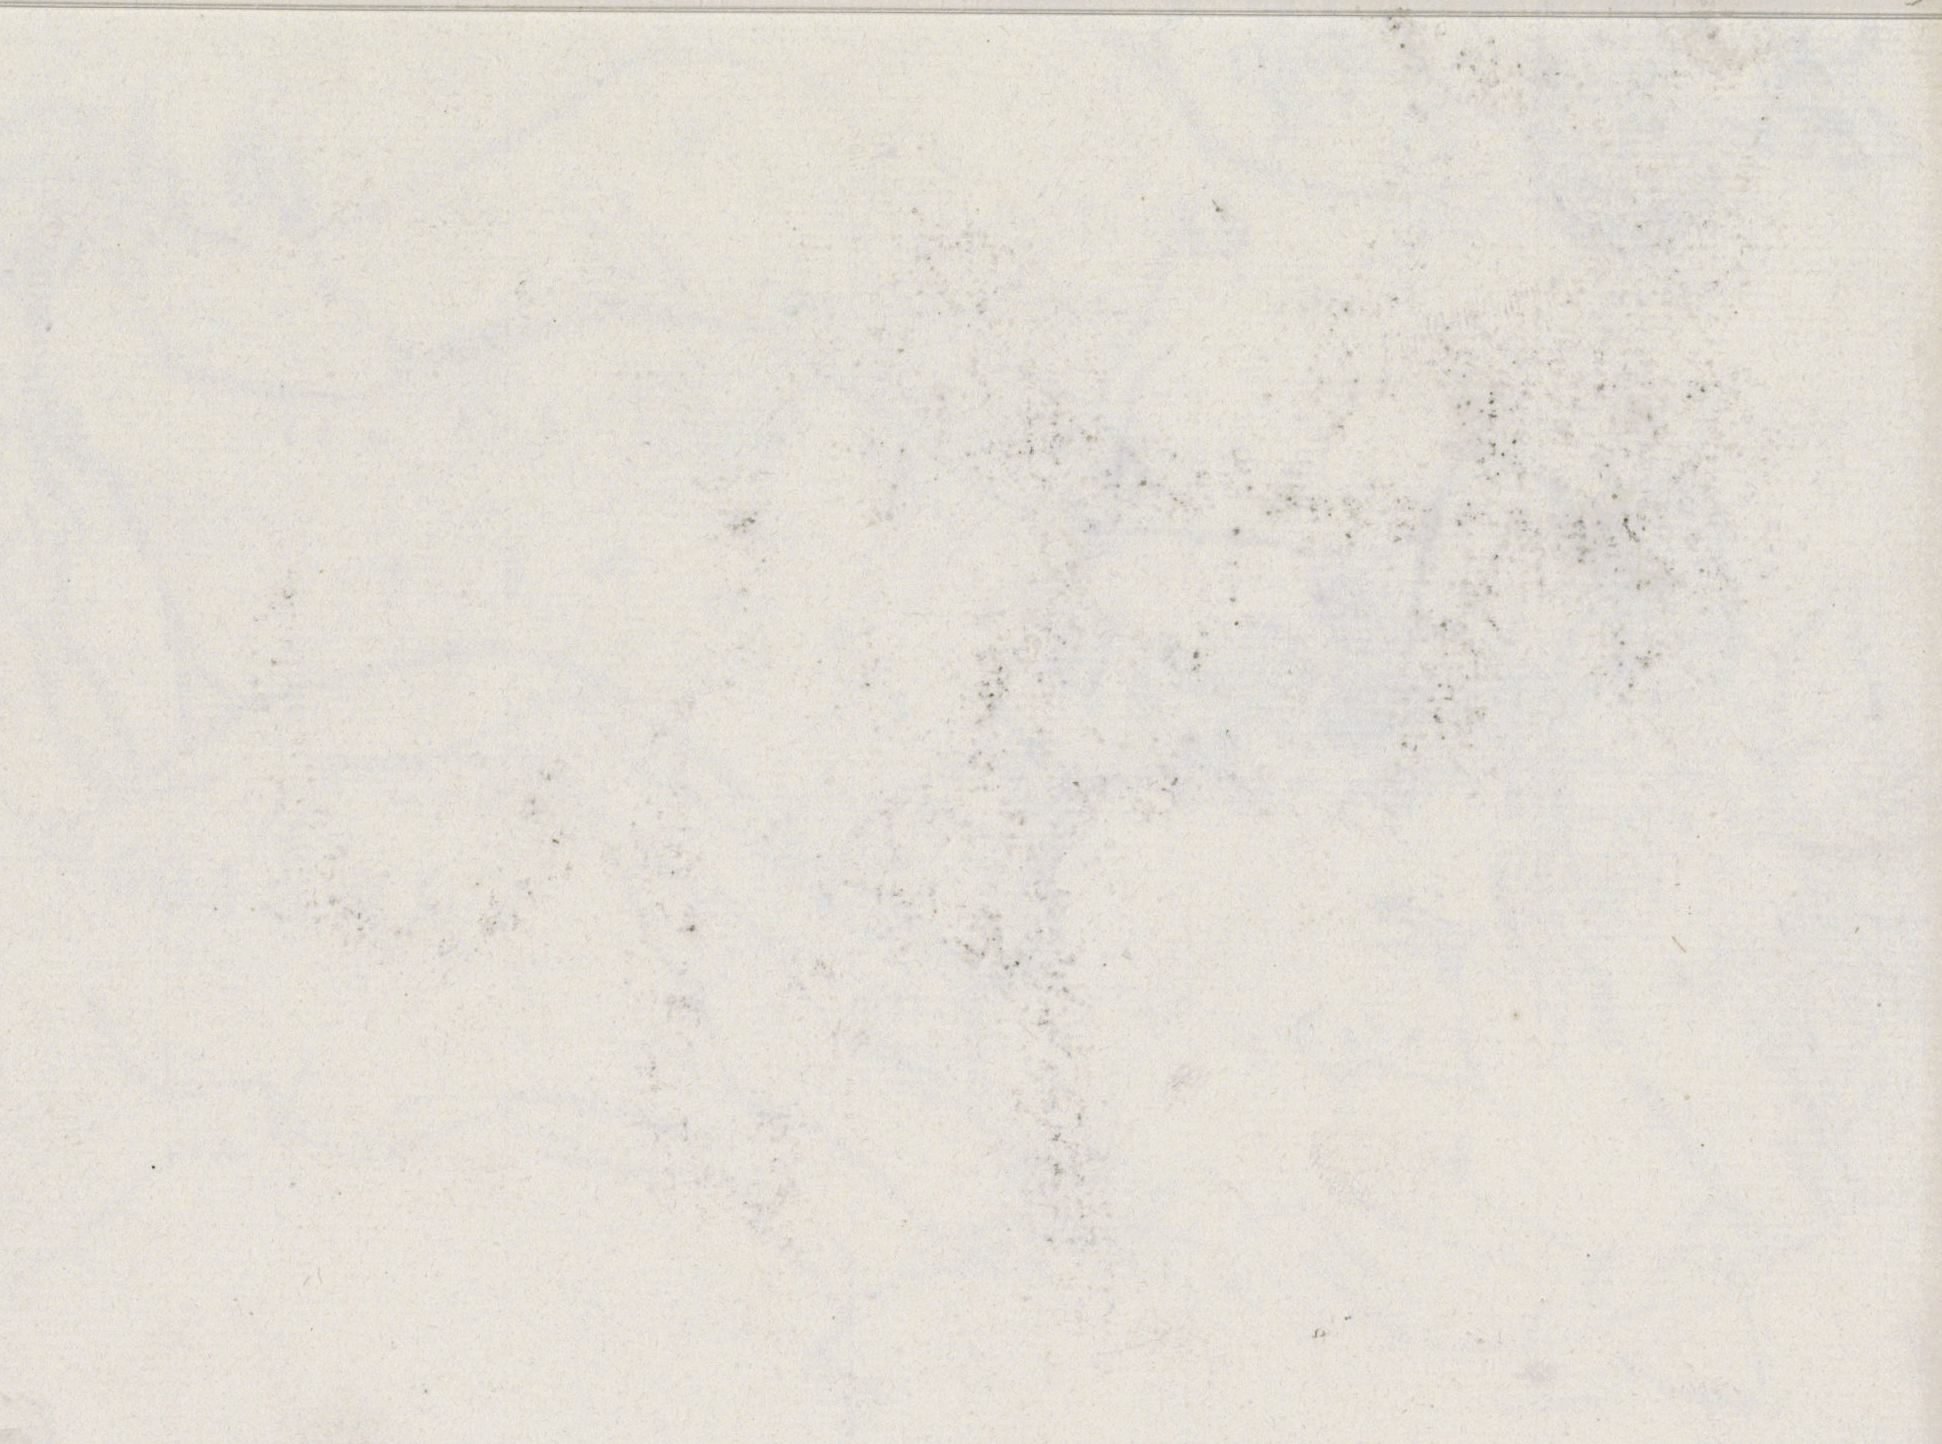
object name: sketchbook leaf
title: Aklatsch van de krijttekening op pagina 28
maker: isaac israels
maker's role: draughtsman, painter, print maker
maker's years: 1865-1934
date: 1875-1934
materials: paper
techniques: printmaking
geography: the hague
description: Pagina 29 uit schetsboek XLI met 38 pagina's.